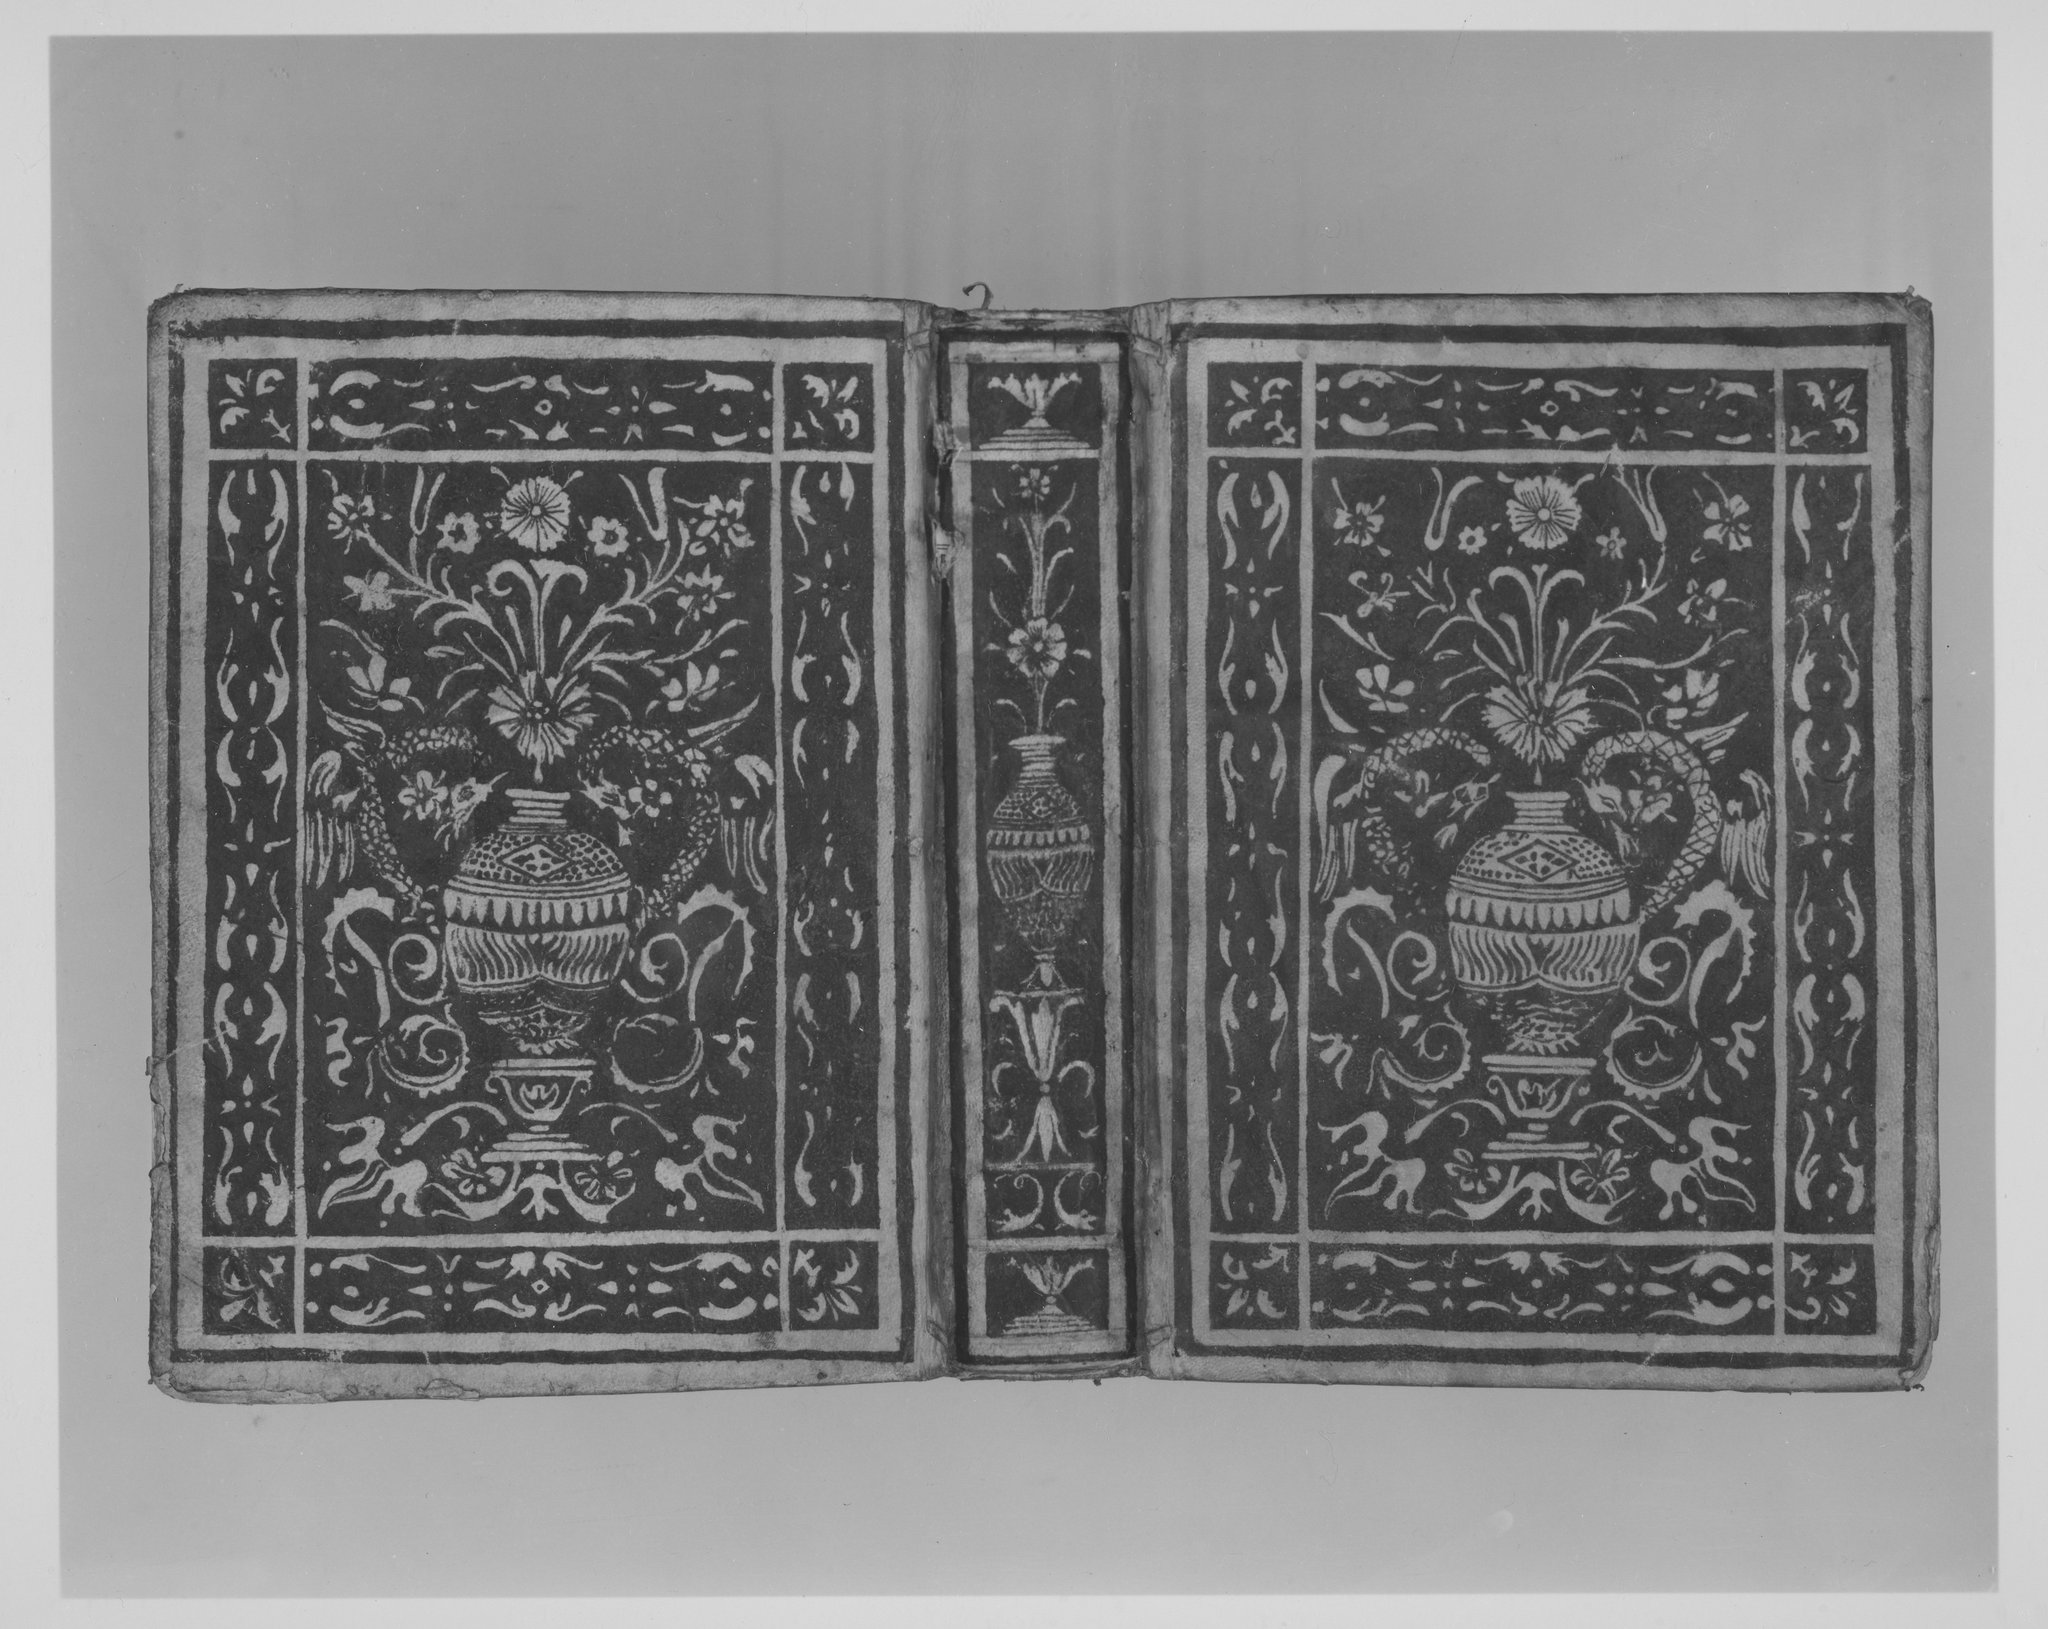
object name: book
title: Postilla super Epistolas et Evangelia; bound with Passio domini Nostri Jesu Christo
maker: guillermus parisiensis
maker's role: author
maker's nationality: french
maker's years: 1437-1485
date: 1521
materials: parchment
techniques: bookbinding, woodcut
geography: germany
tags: flowers,leaves